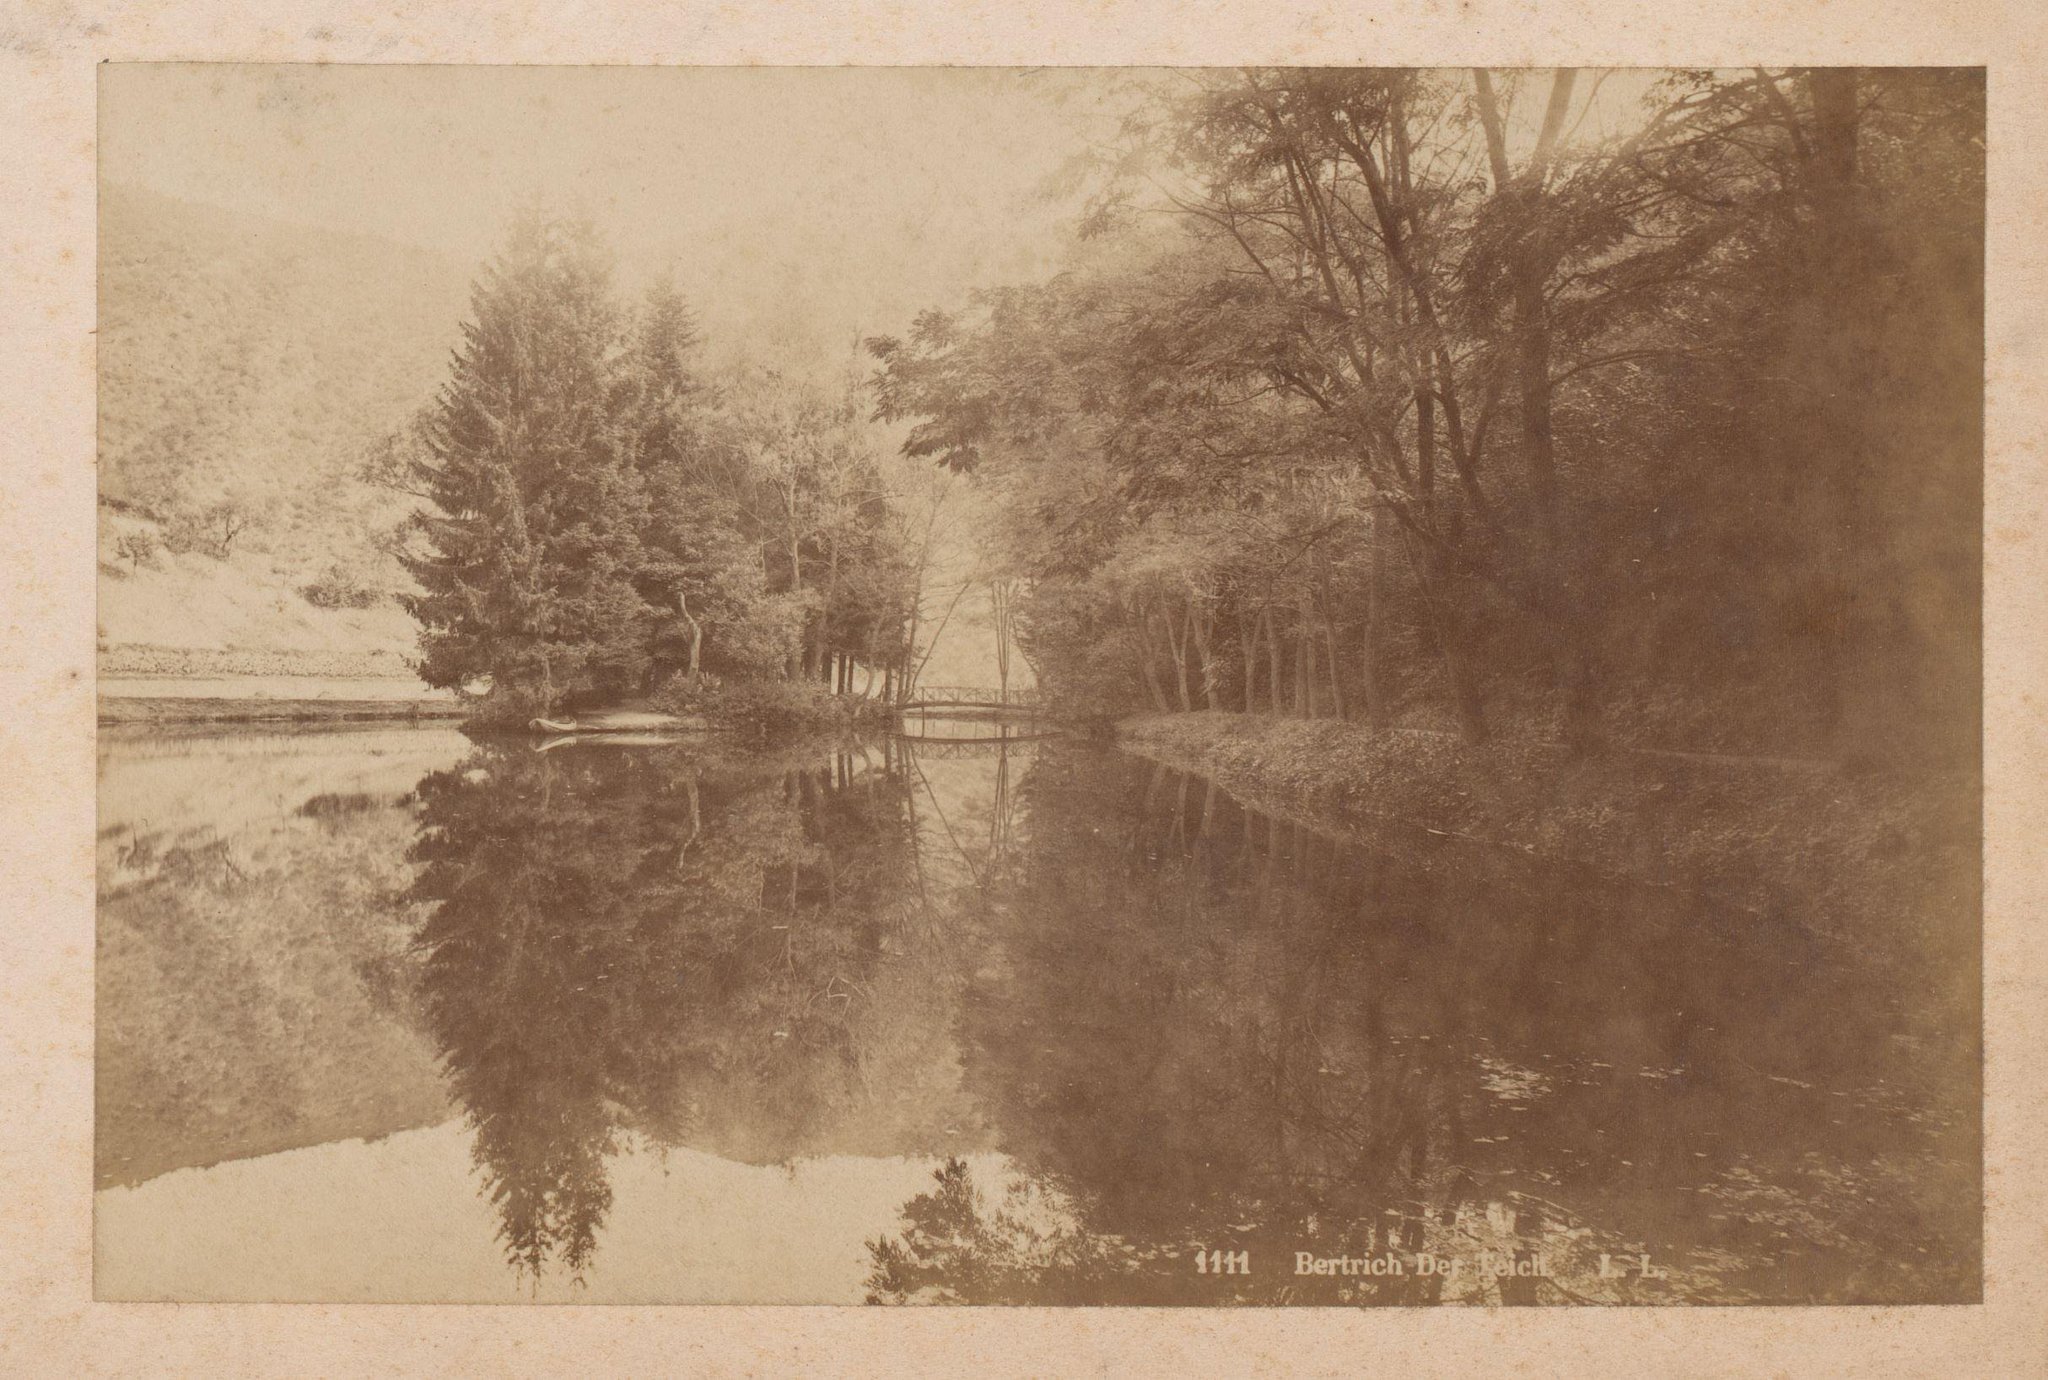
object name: photograph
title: Vijver in Bad Bertrich, Rijnland-Palts, Duitsland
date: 1880-1910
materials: cardboard, paper, photographic support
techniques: albumen print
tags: rijnland-palts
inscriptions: inscription: ‘L.L.’, inscription: ‘1111. Bertrich Der Teich’